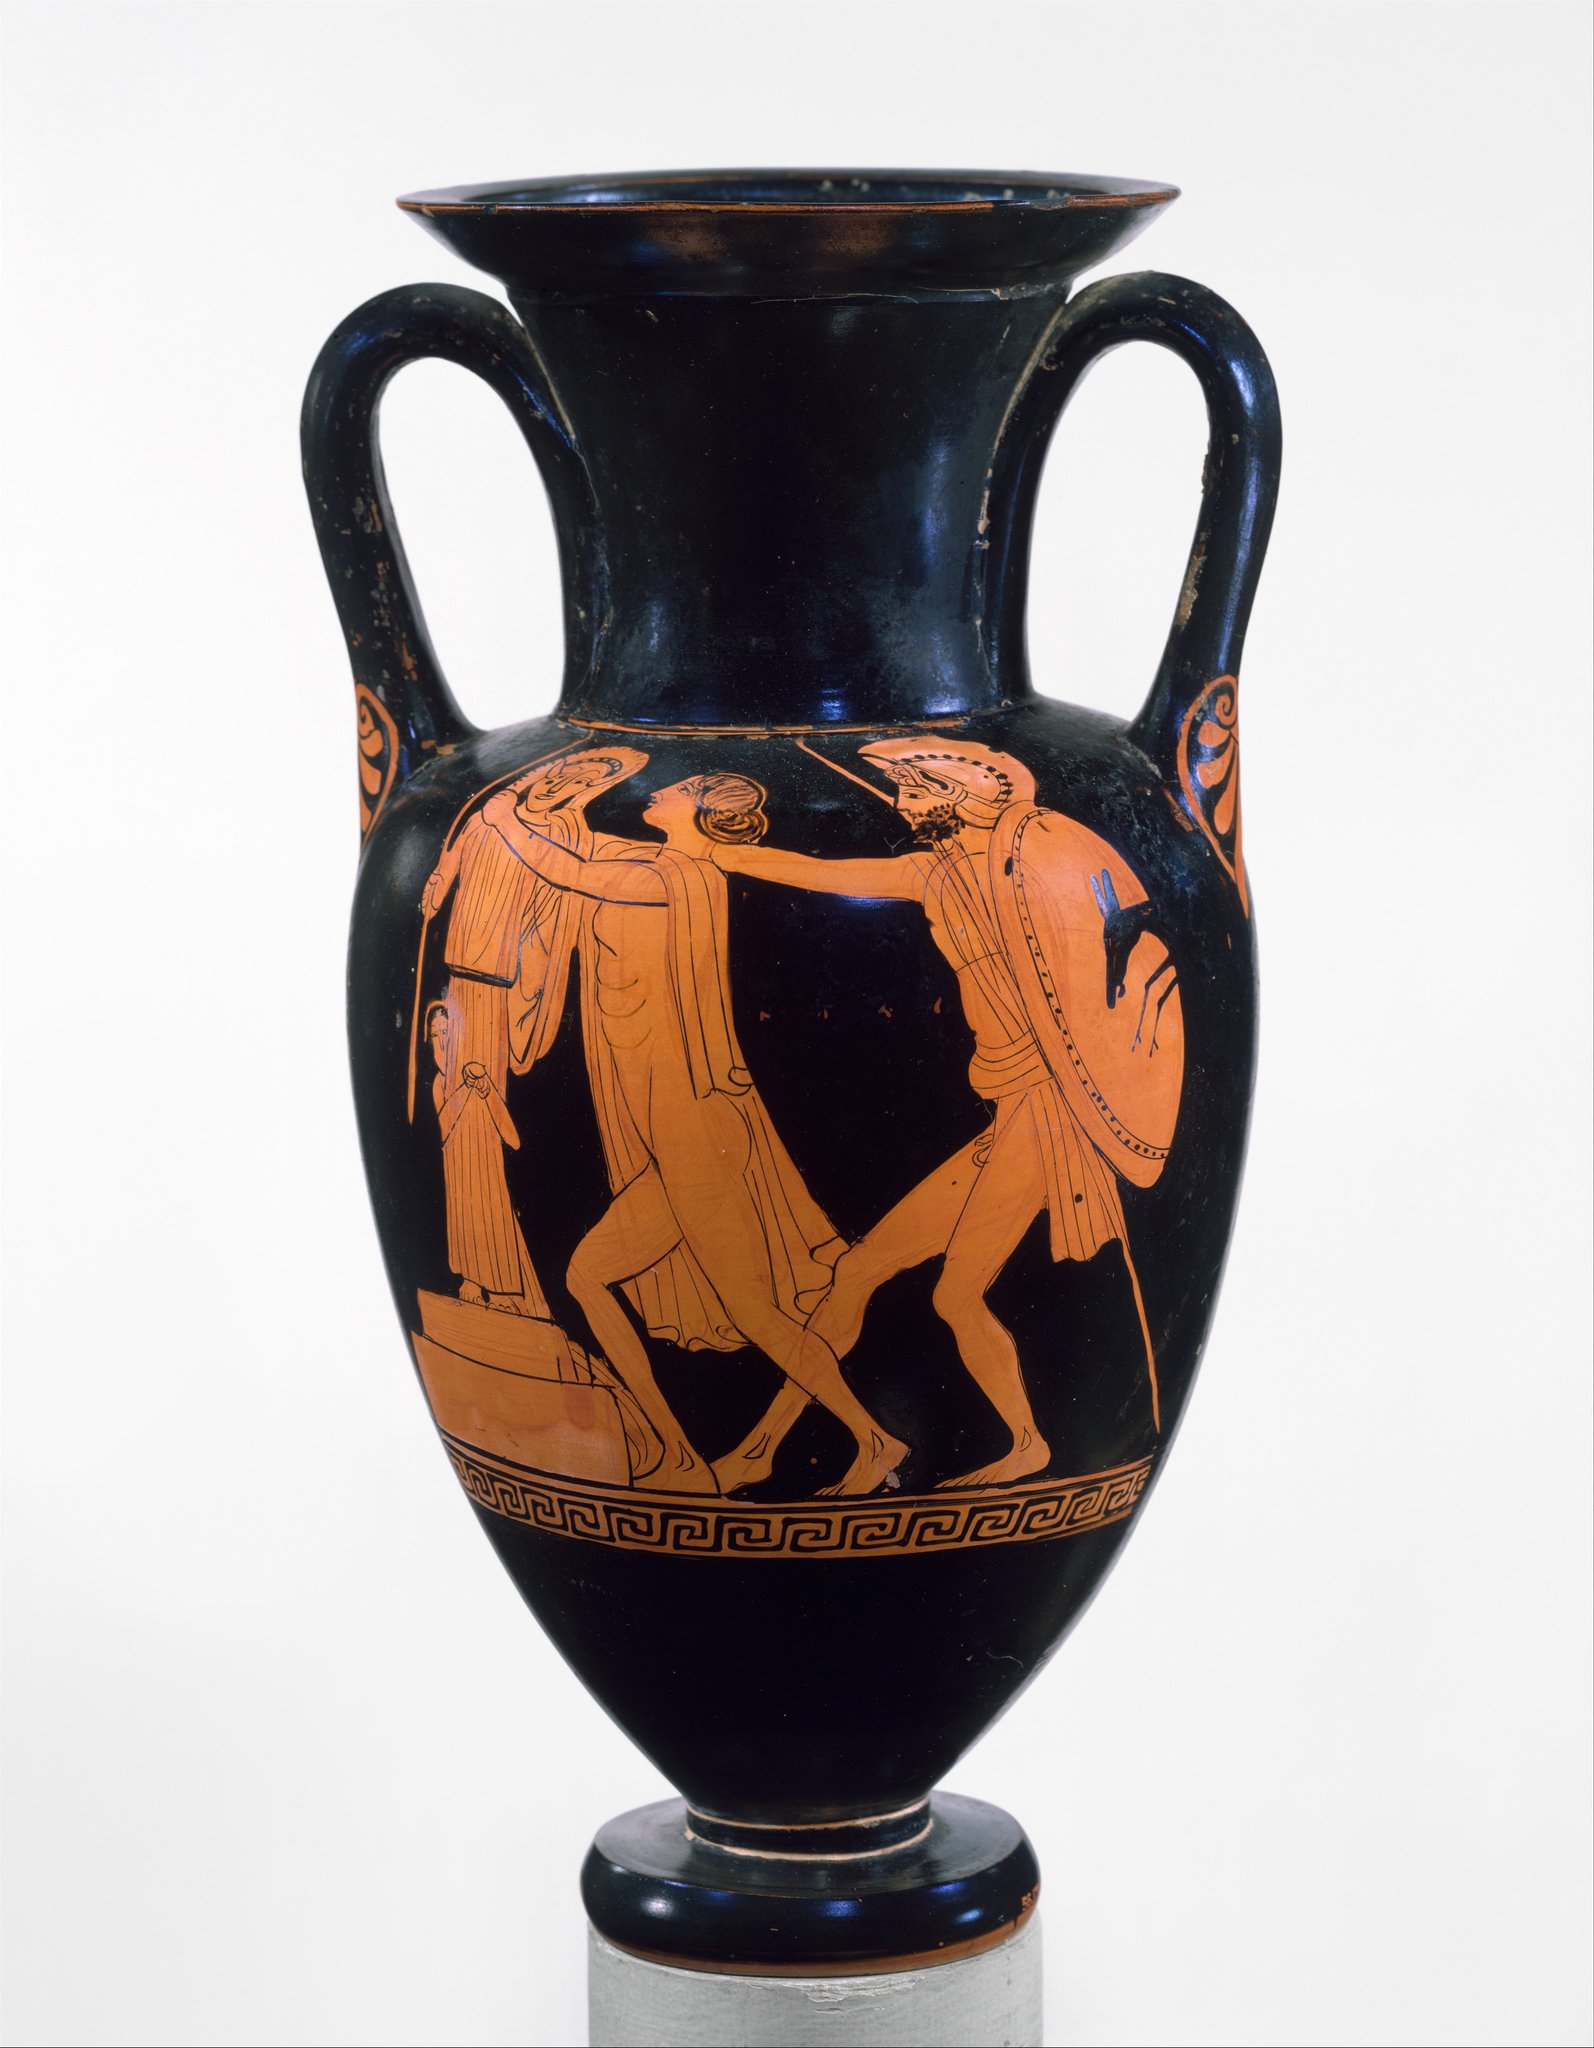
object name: nolan neck amphora with ridged handle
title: Terracotta Nolan neck-amphora (jar)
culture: greek, attic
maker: ethiop painter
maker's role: artist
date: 450 BCE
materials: terracotta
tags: women,athena,ajax